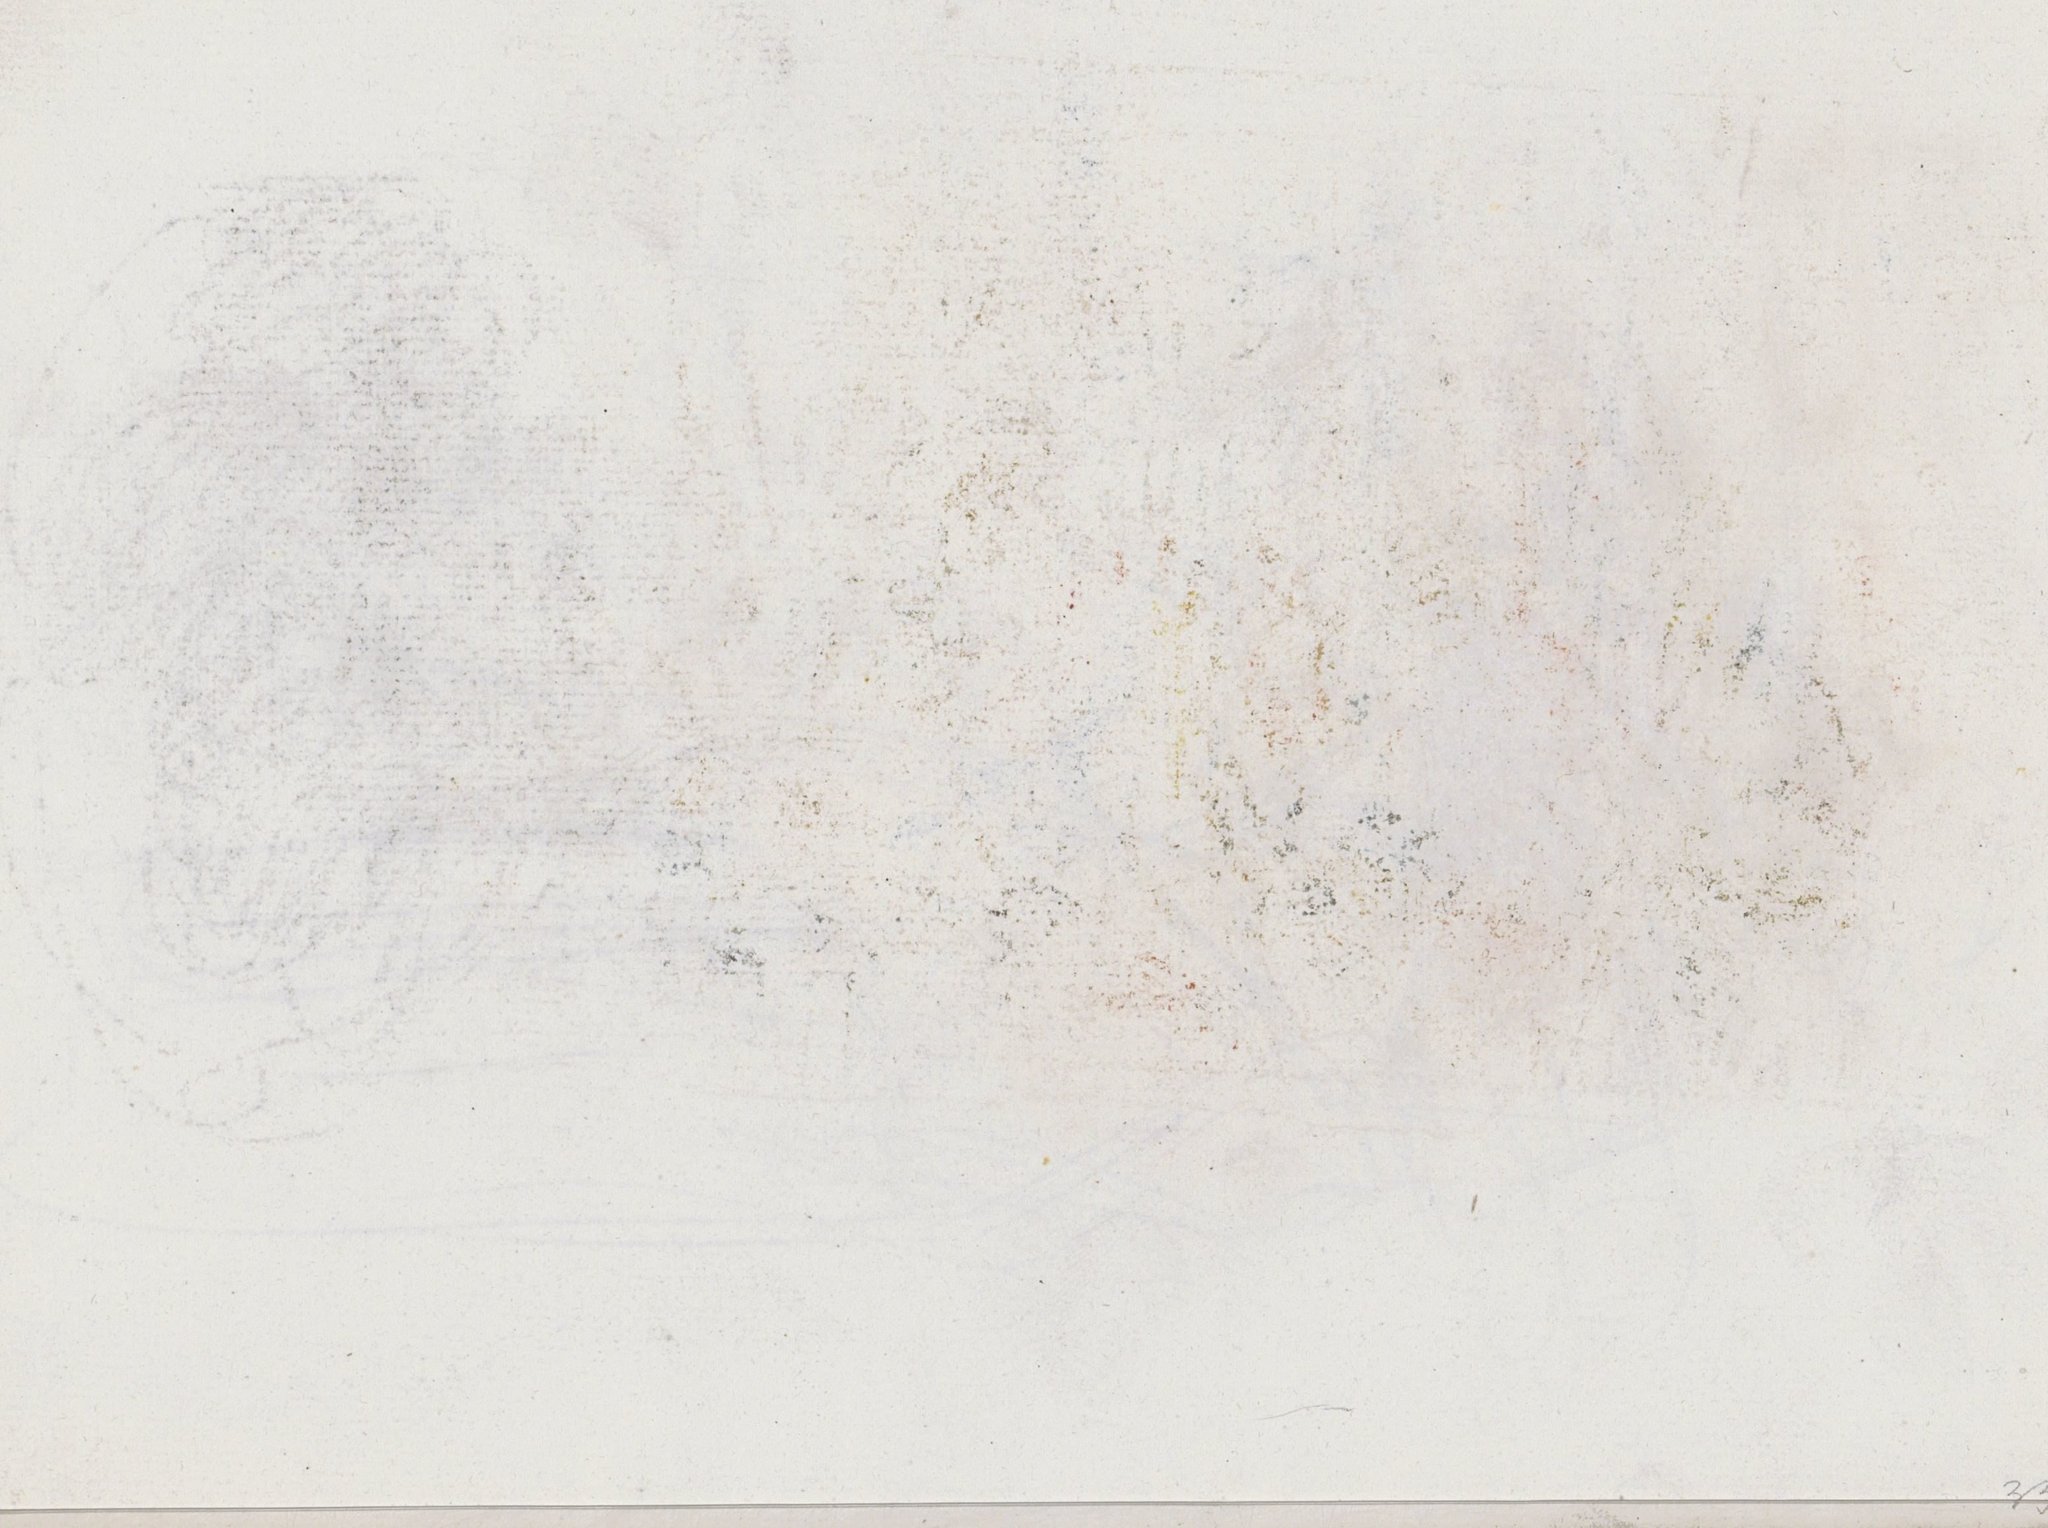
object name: sketchbook leaf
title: Abklatsch van de krijttekening op blad 3 recto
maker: isaac israels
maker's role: draughtsman, painter, print maker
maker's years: 1865-1934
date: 1875-1934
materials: paper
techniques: printmaking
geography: the hague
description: Blad 2 verso uit schetsboek XXII met 30 bladen.